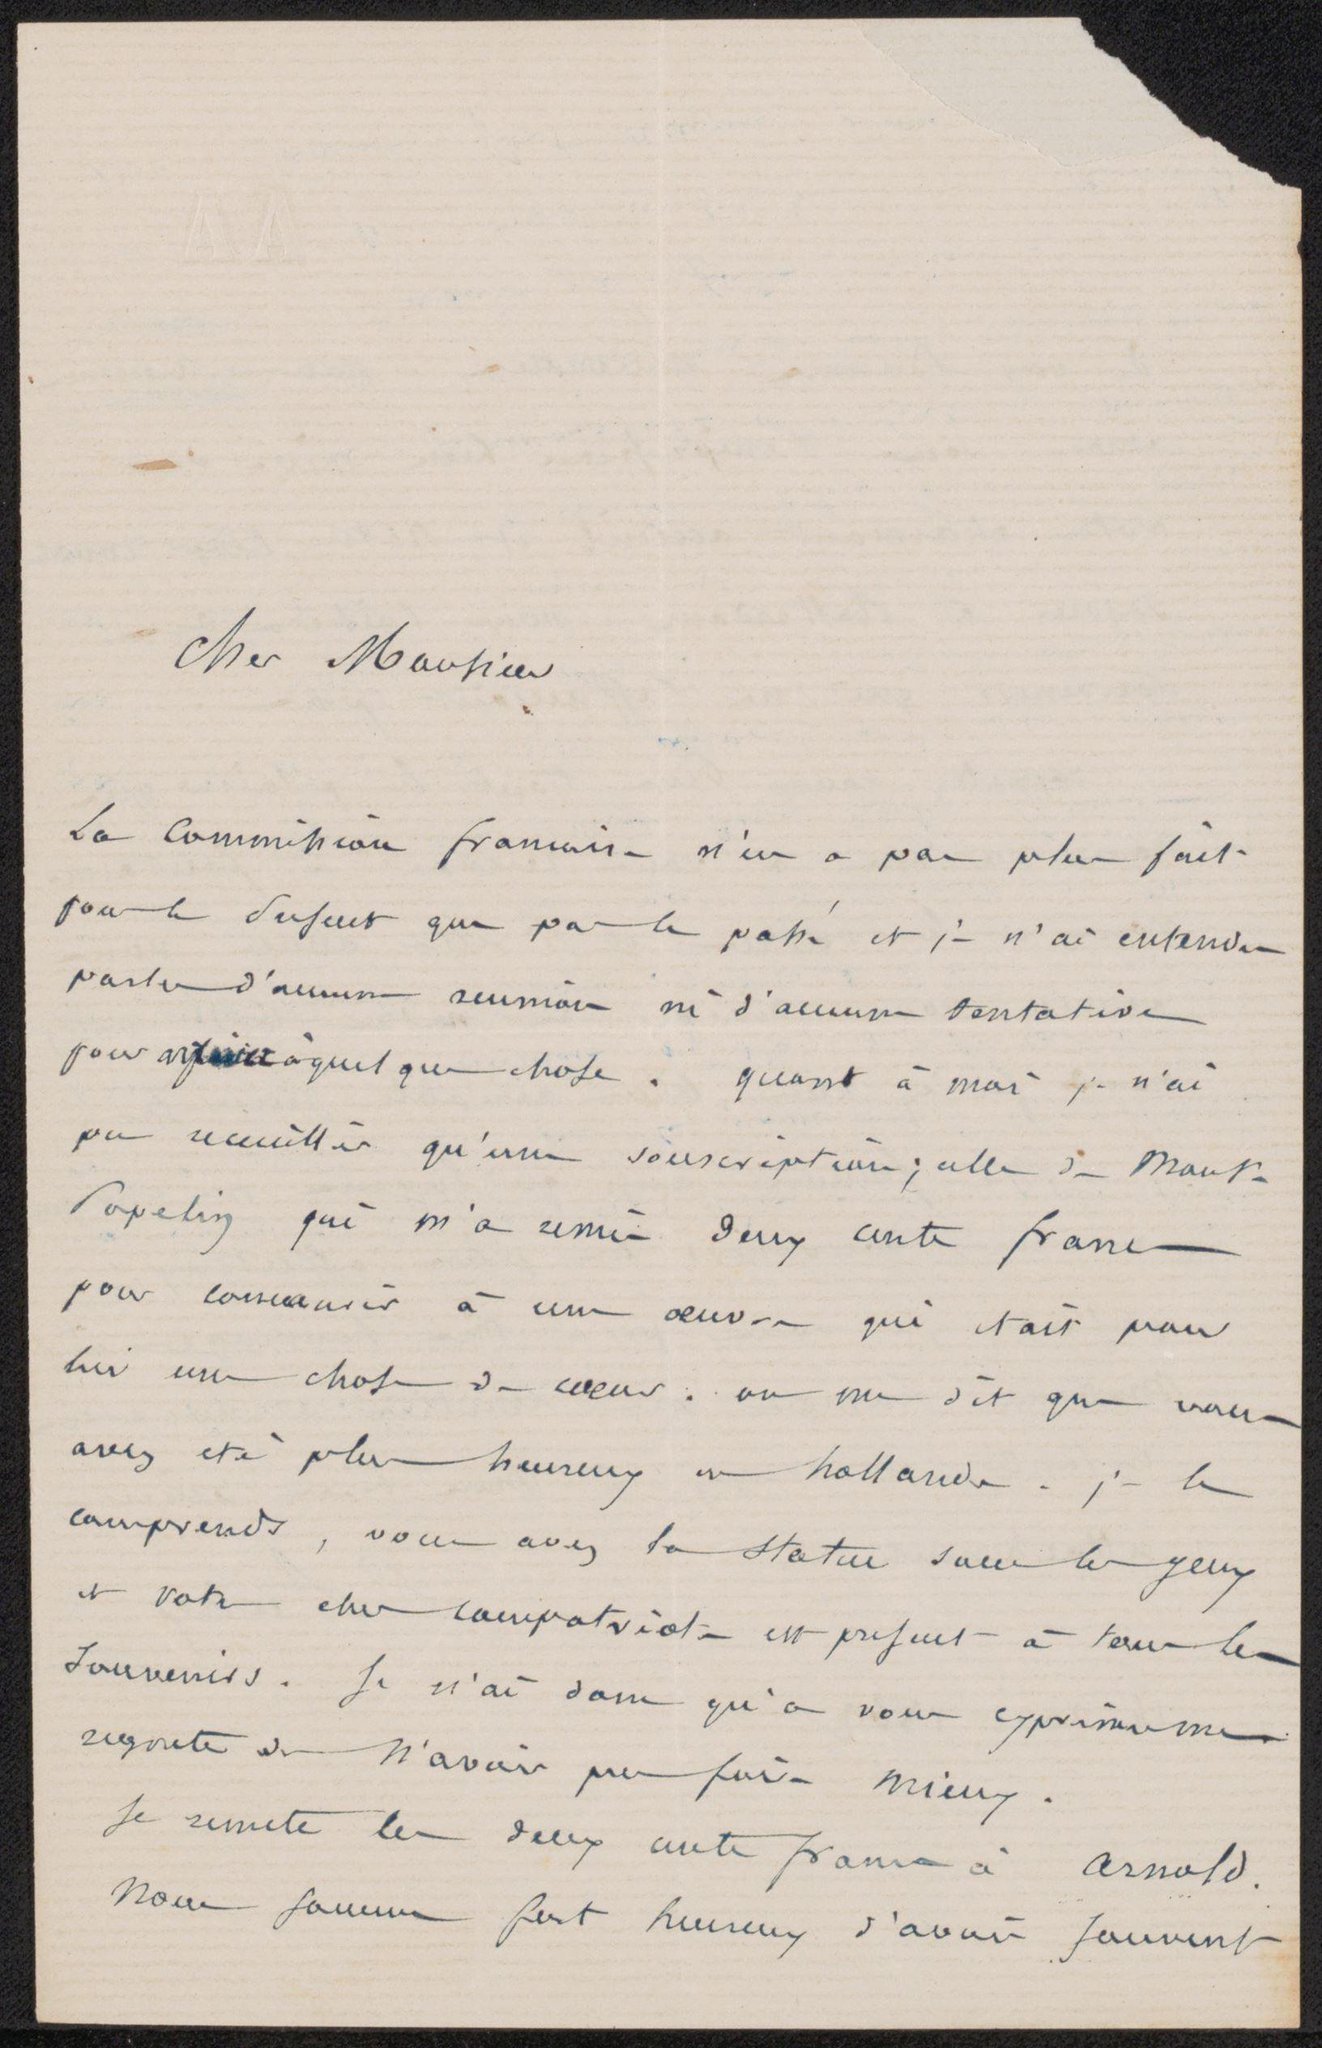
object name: letter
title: Brief aan Ary Johannes Lamme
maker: e. aubry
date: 1862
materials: ink, paper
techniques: pen, writing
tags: dordrecht, print maker, draughtsman, ary johannes lamme, rotterdam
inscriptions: initials: ‘AA’, collector's mark: Lugt 2228